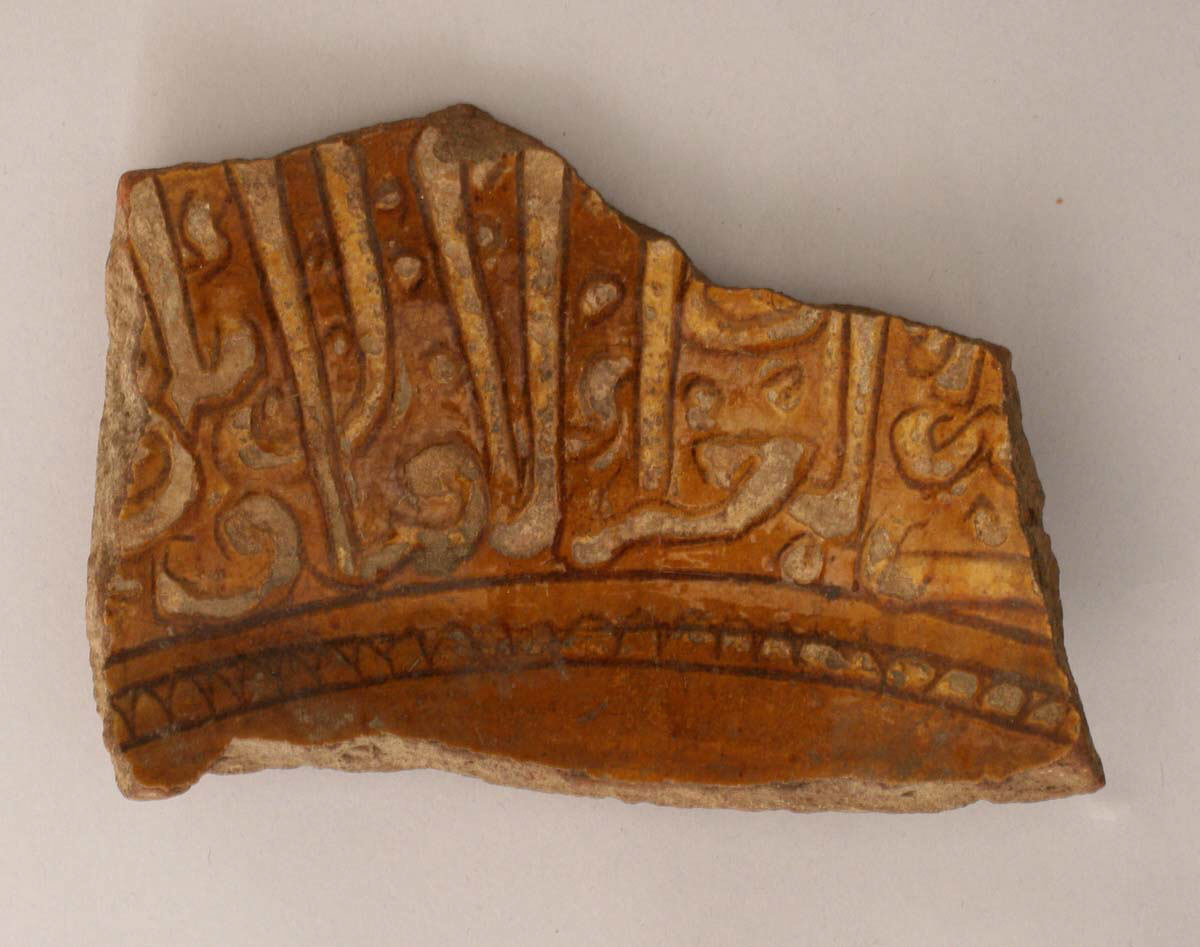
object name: fragment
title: Ceramic Fragment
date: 1301-1500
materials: earthenware, glaze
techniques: coloring, incising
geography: egypt